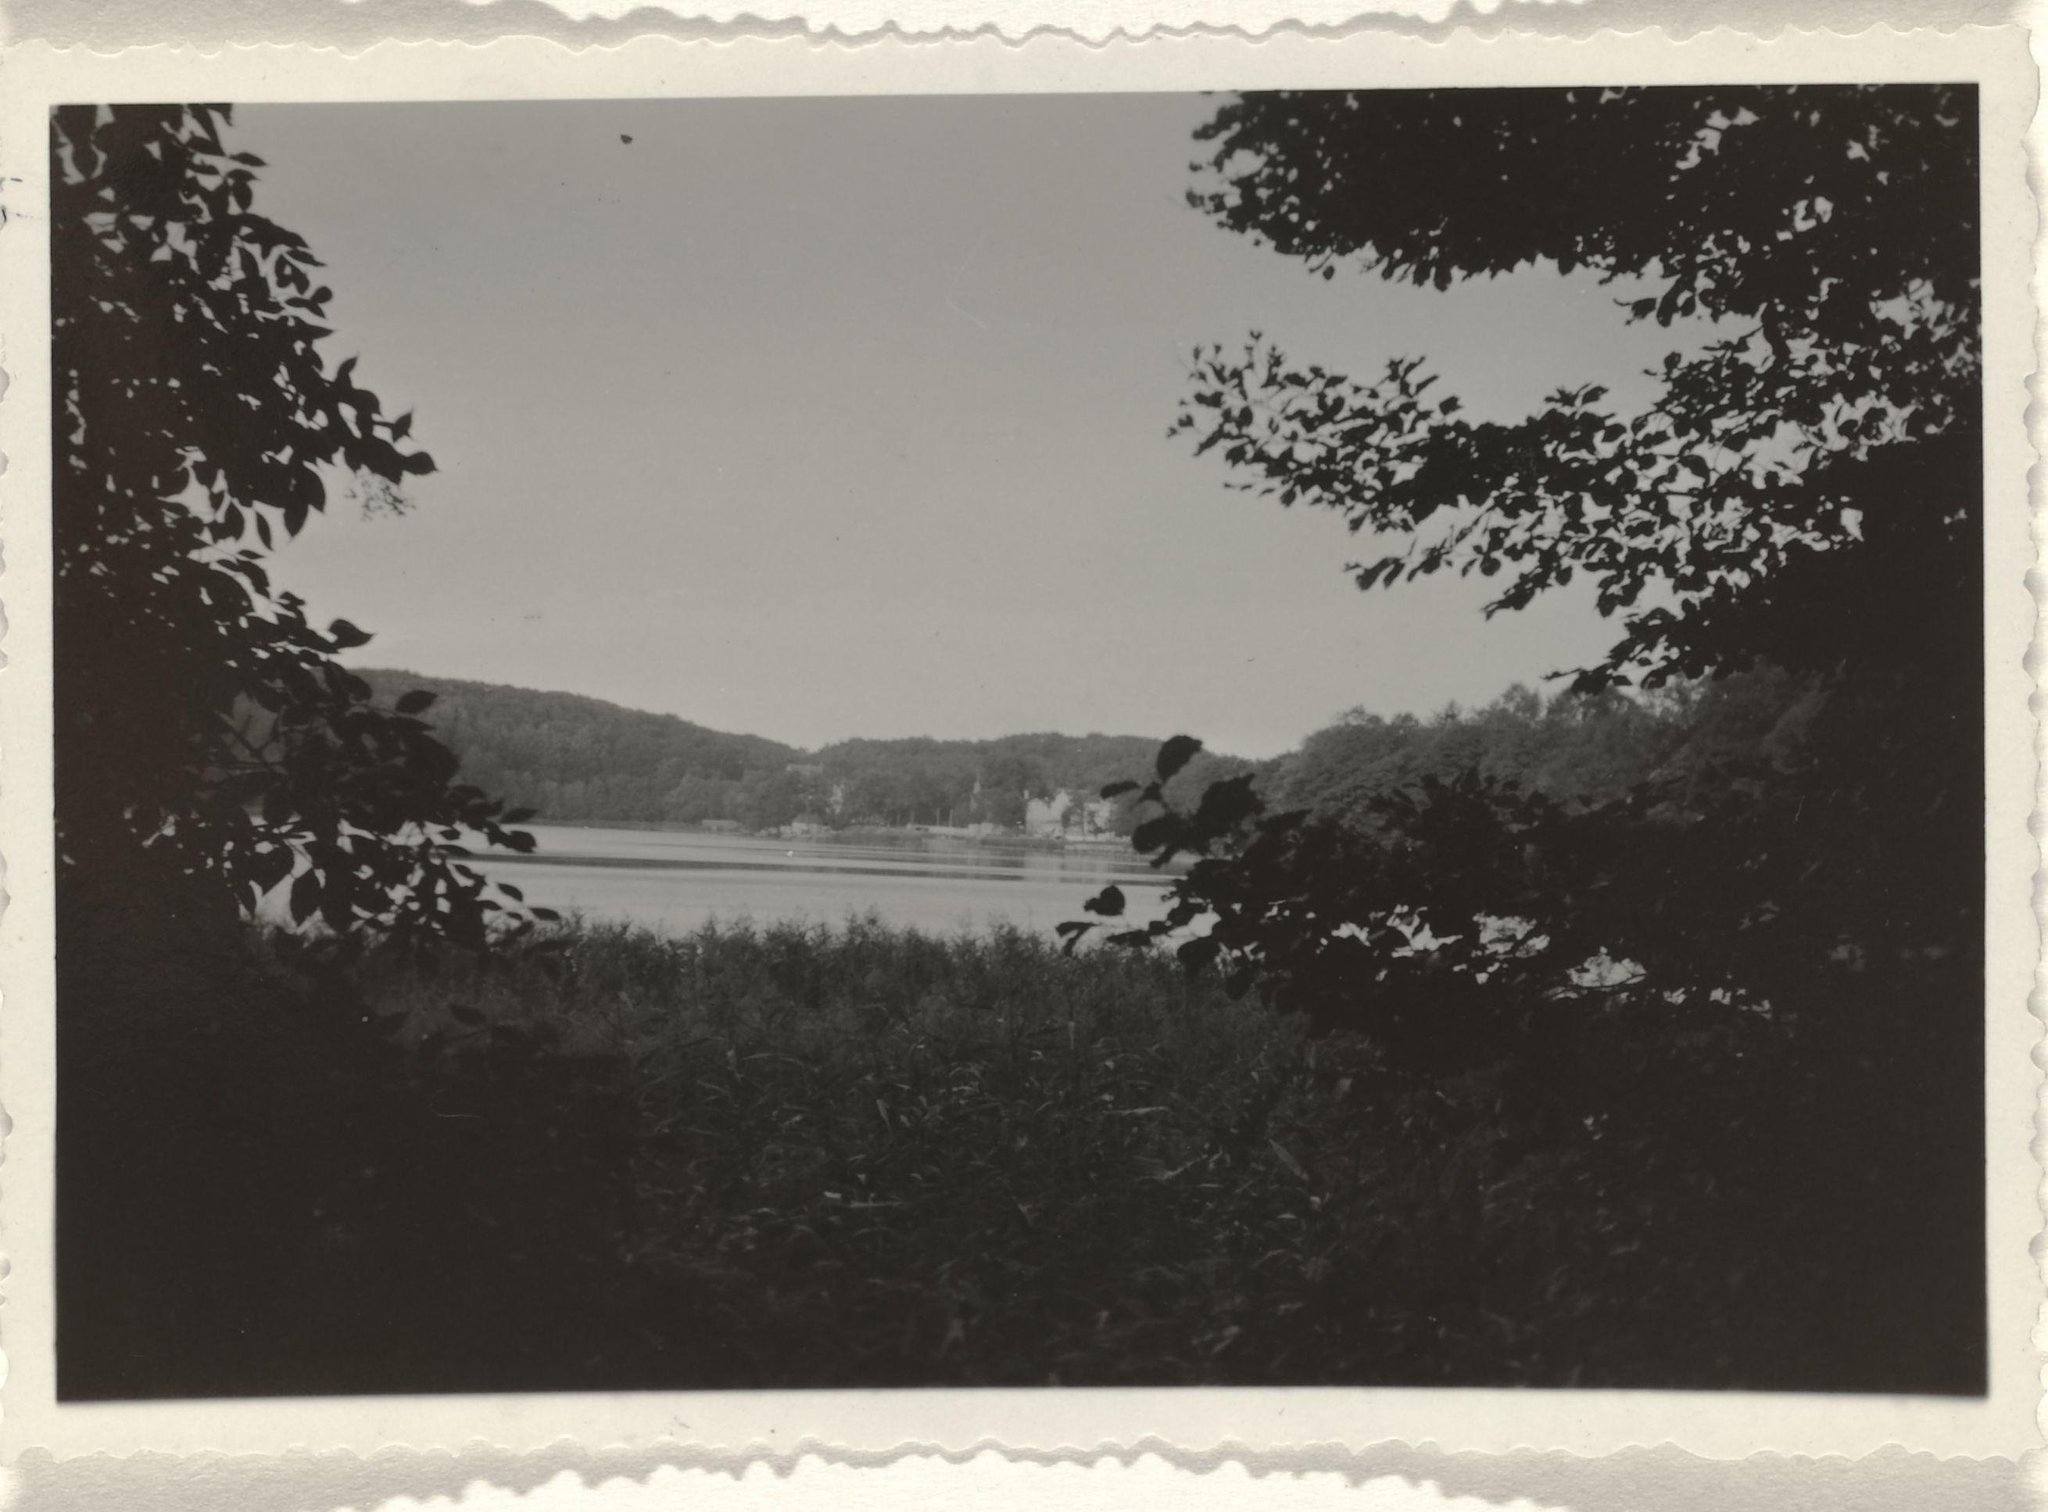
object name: photograph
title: Met bergen en bos omringd meer bij de Zwitserse plaats Holstein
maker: Anonymous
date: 1909-1934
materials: photographic support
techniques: gelatin silver print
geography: switzerland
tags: trübsee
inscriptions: date: ‘Sept. 34. 12’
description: Zicht op een met bergen en bos omringd meer.